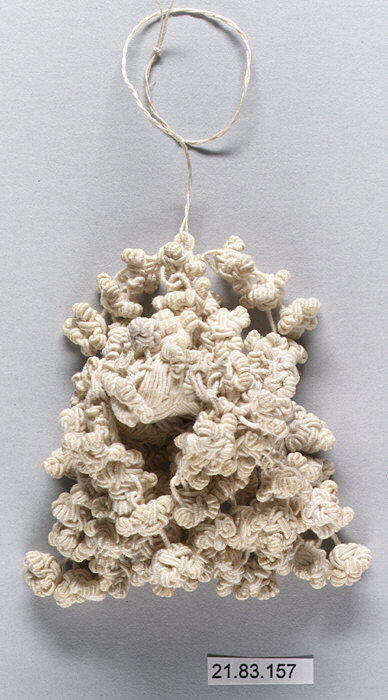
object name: tassel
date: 1601-1700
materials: linen